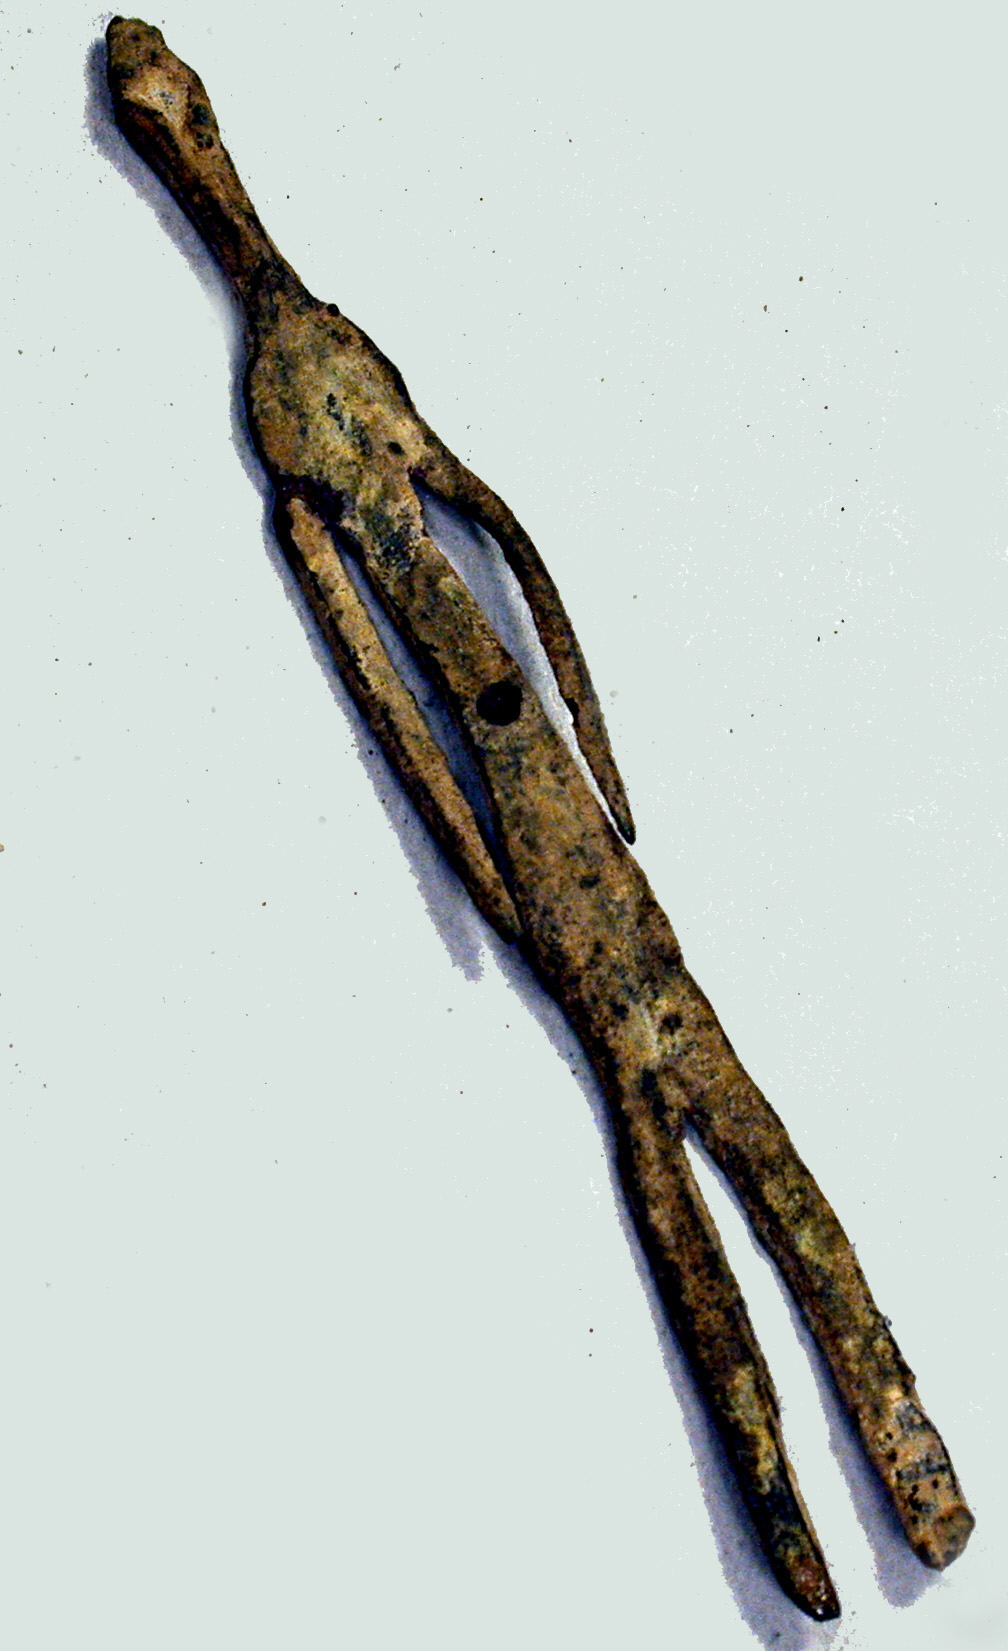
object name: figure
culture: middle niger civilization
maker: middle niger artist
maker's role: artist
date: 1101-1600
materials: copper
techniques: hammering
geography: mali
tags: human figures